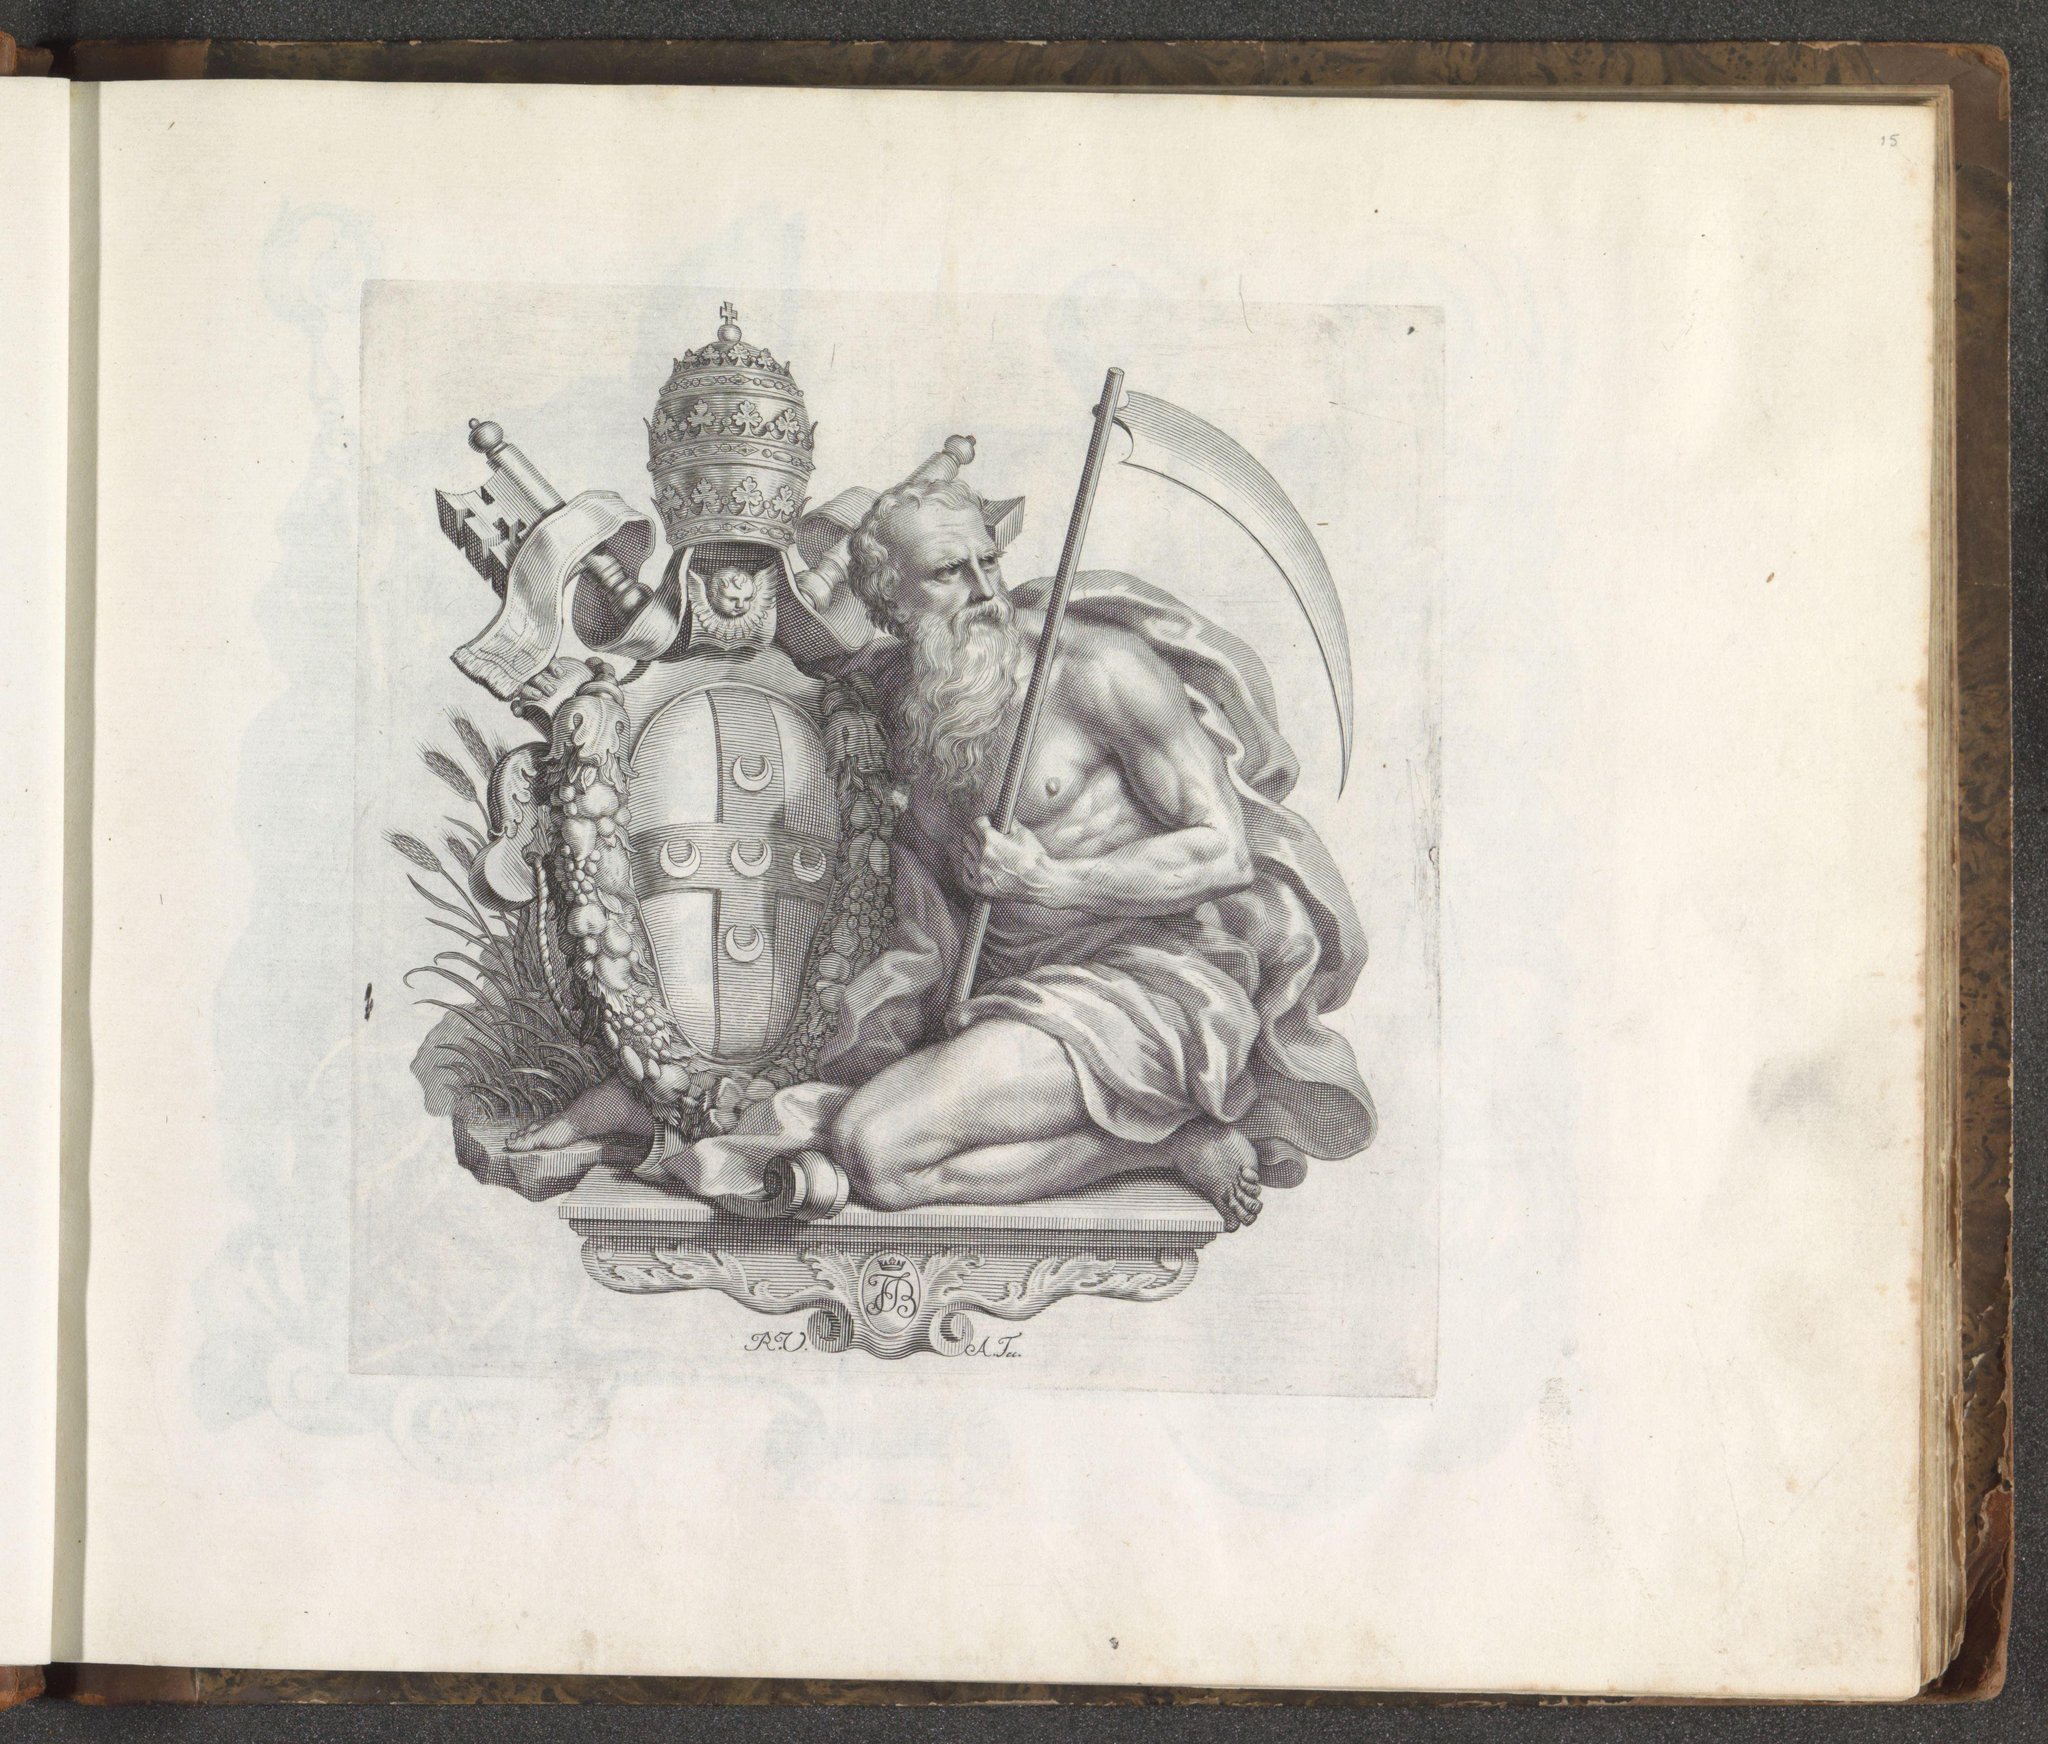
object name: album leaf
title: Personificatie van het Latijnse rijk met het pauselijk wapen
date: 1673-1743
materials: paper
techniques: engraving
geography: rome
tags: rome, coat of arms (as symbol of the state, etc.), (story of) saturn (cronus), personifications of countries, nations, states, districts, etc., insignia of the pope, e.g. tiara, italy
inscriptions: collector's mark: Lugt 2228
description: Een console met een pauselijk wapen, bekroond met een tiara en twee gekruiste sleutels. Het betreft het wapen van paus Pius II of paus Pius III. Saturnus, met zeis en korenaren, is hier mogelijk bedoeld als personificatie van het Latijnse rijk. De prent maakt deel uit van een album.